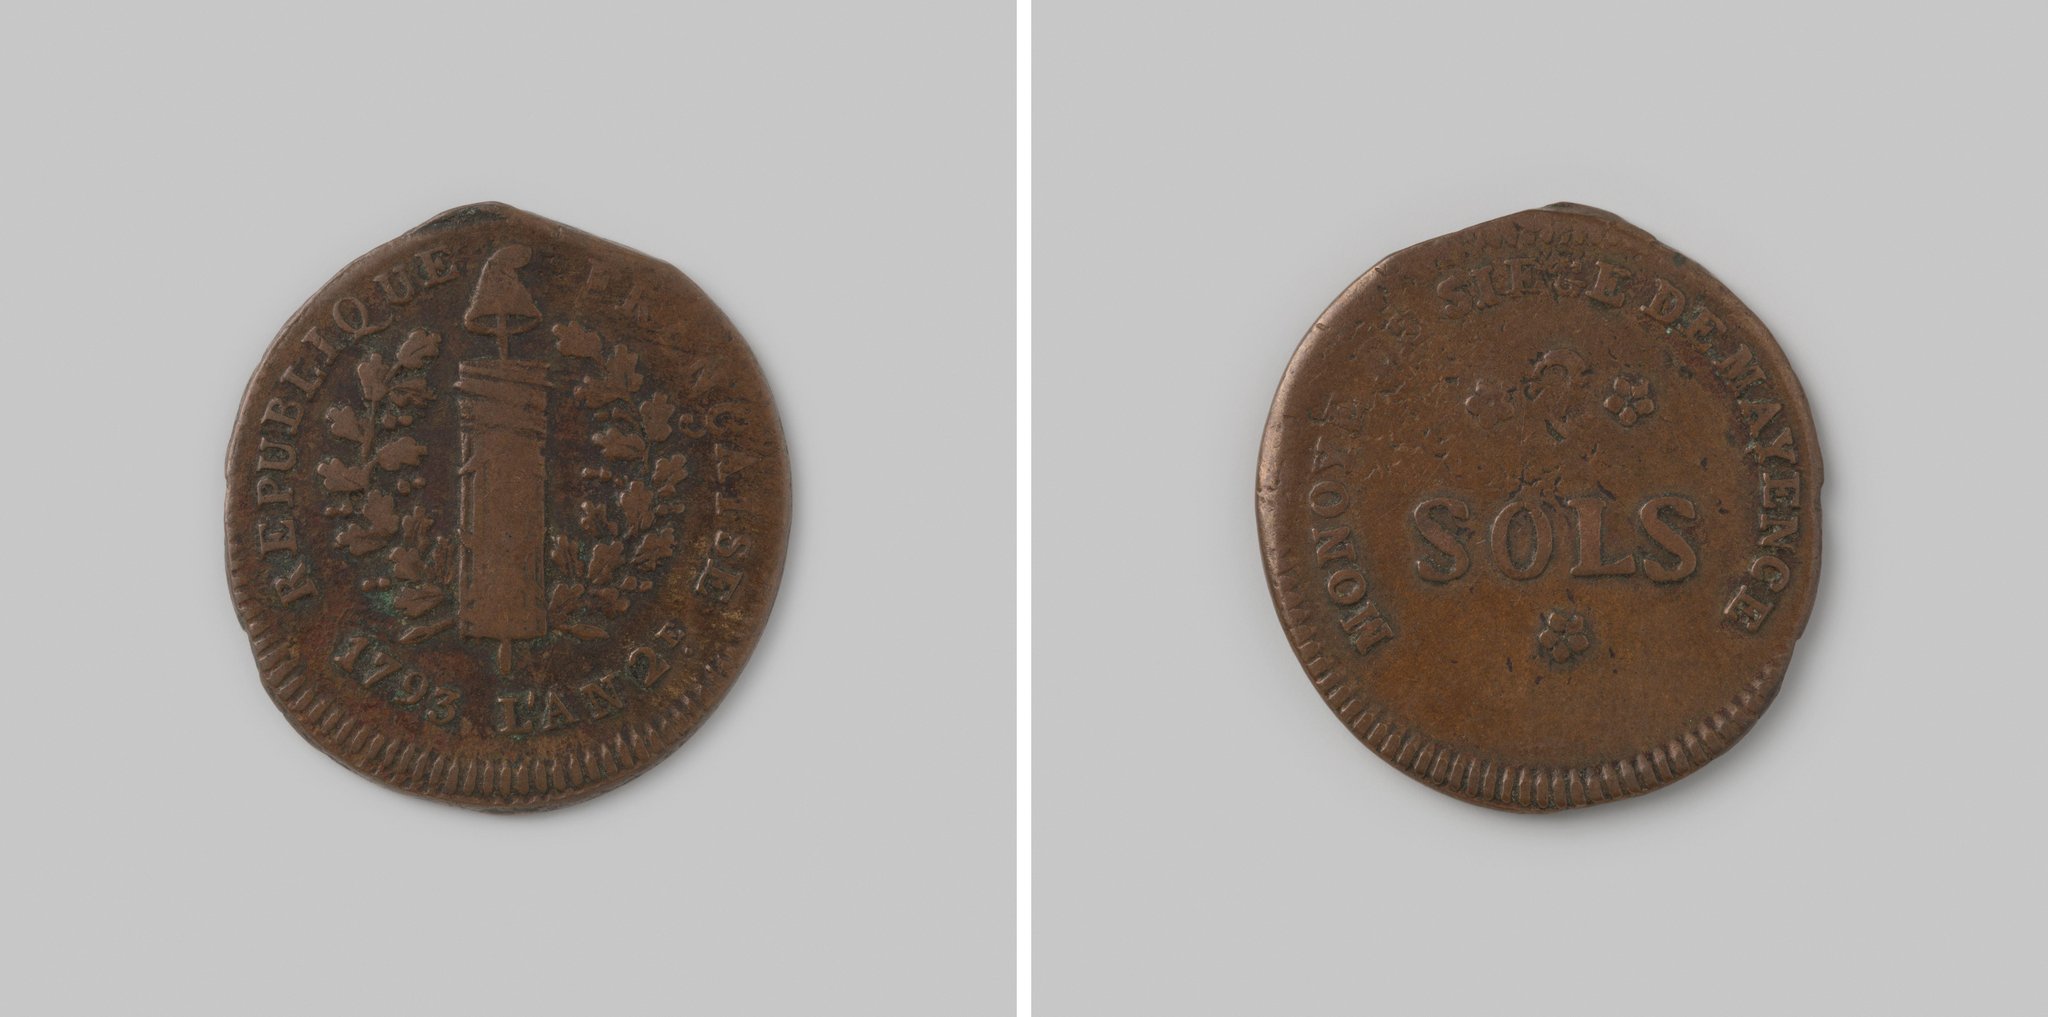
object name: siege coin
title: Noodmunt van 2 sols uit Mainz, Hessen tijdens belegering door de Verbondenen, 1793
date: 1793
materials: copper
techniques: striking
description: Koperen noodmunt. Voorzijde: binnen twee takken houder voor pijlen, waarop vrijheidshoed. Jaartal onderaan. Keerzijde: in twee regels waarde-aanduiding: 2 sols.